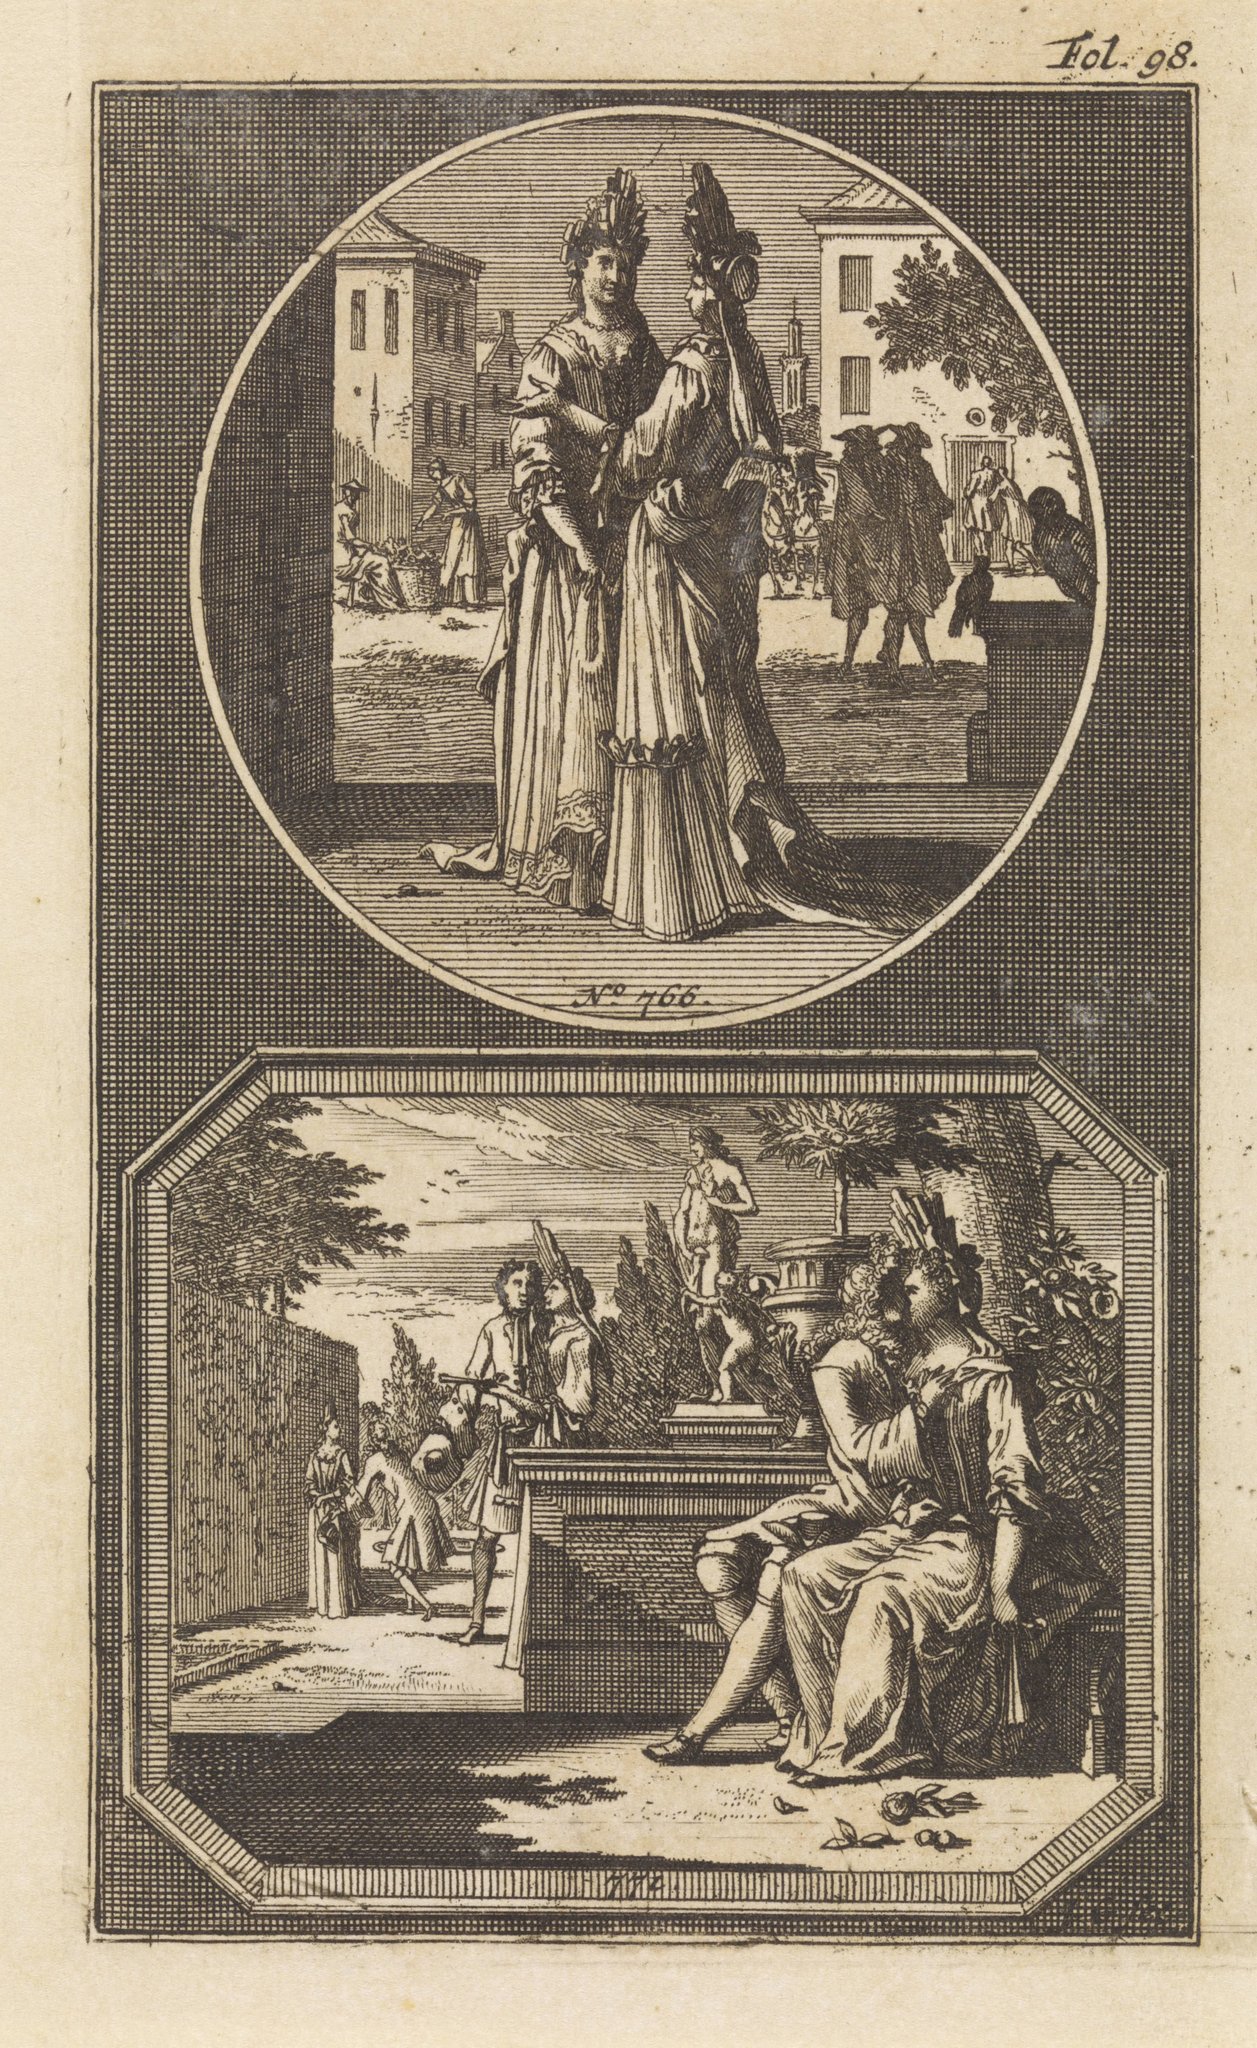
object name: book illustration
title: Roddelende vrouwen / vrijend paartje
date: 1705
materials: paper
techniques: engraving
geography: amsterdam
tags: (lovers) kissing each other, french or architectonic garden; formal garden, (story of) venus (aphrodite)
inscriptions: collector's mark: Lugt 2760, collector's mark: Lugt 2228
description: Twee voorstellingen van loterijspreuken, elk met een eigen nummer. Boven n. 766: een voorstelling in een ronde lijst van twee roddelende vrouwen in een drukke straat. Onder n. 772: een voorstelling in een achthoekige lijst van een tuin, met op de voorgrond een vrijend paartje. Op de achtergrond twee andere paartjes en eens tandbeeld van Venus en Cupido. De prent heeft een paginanummer bovenaan rechts.